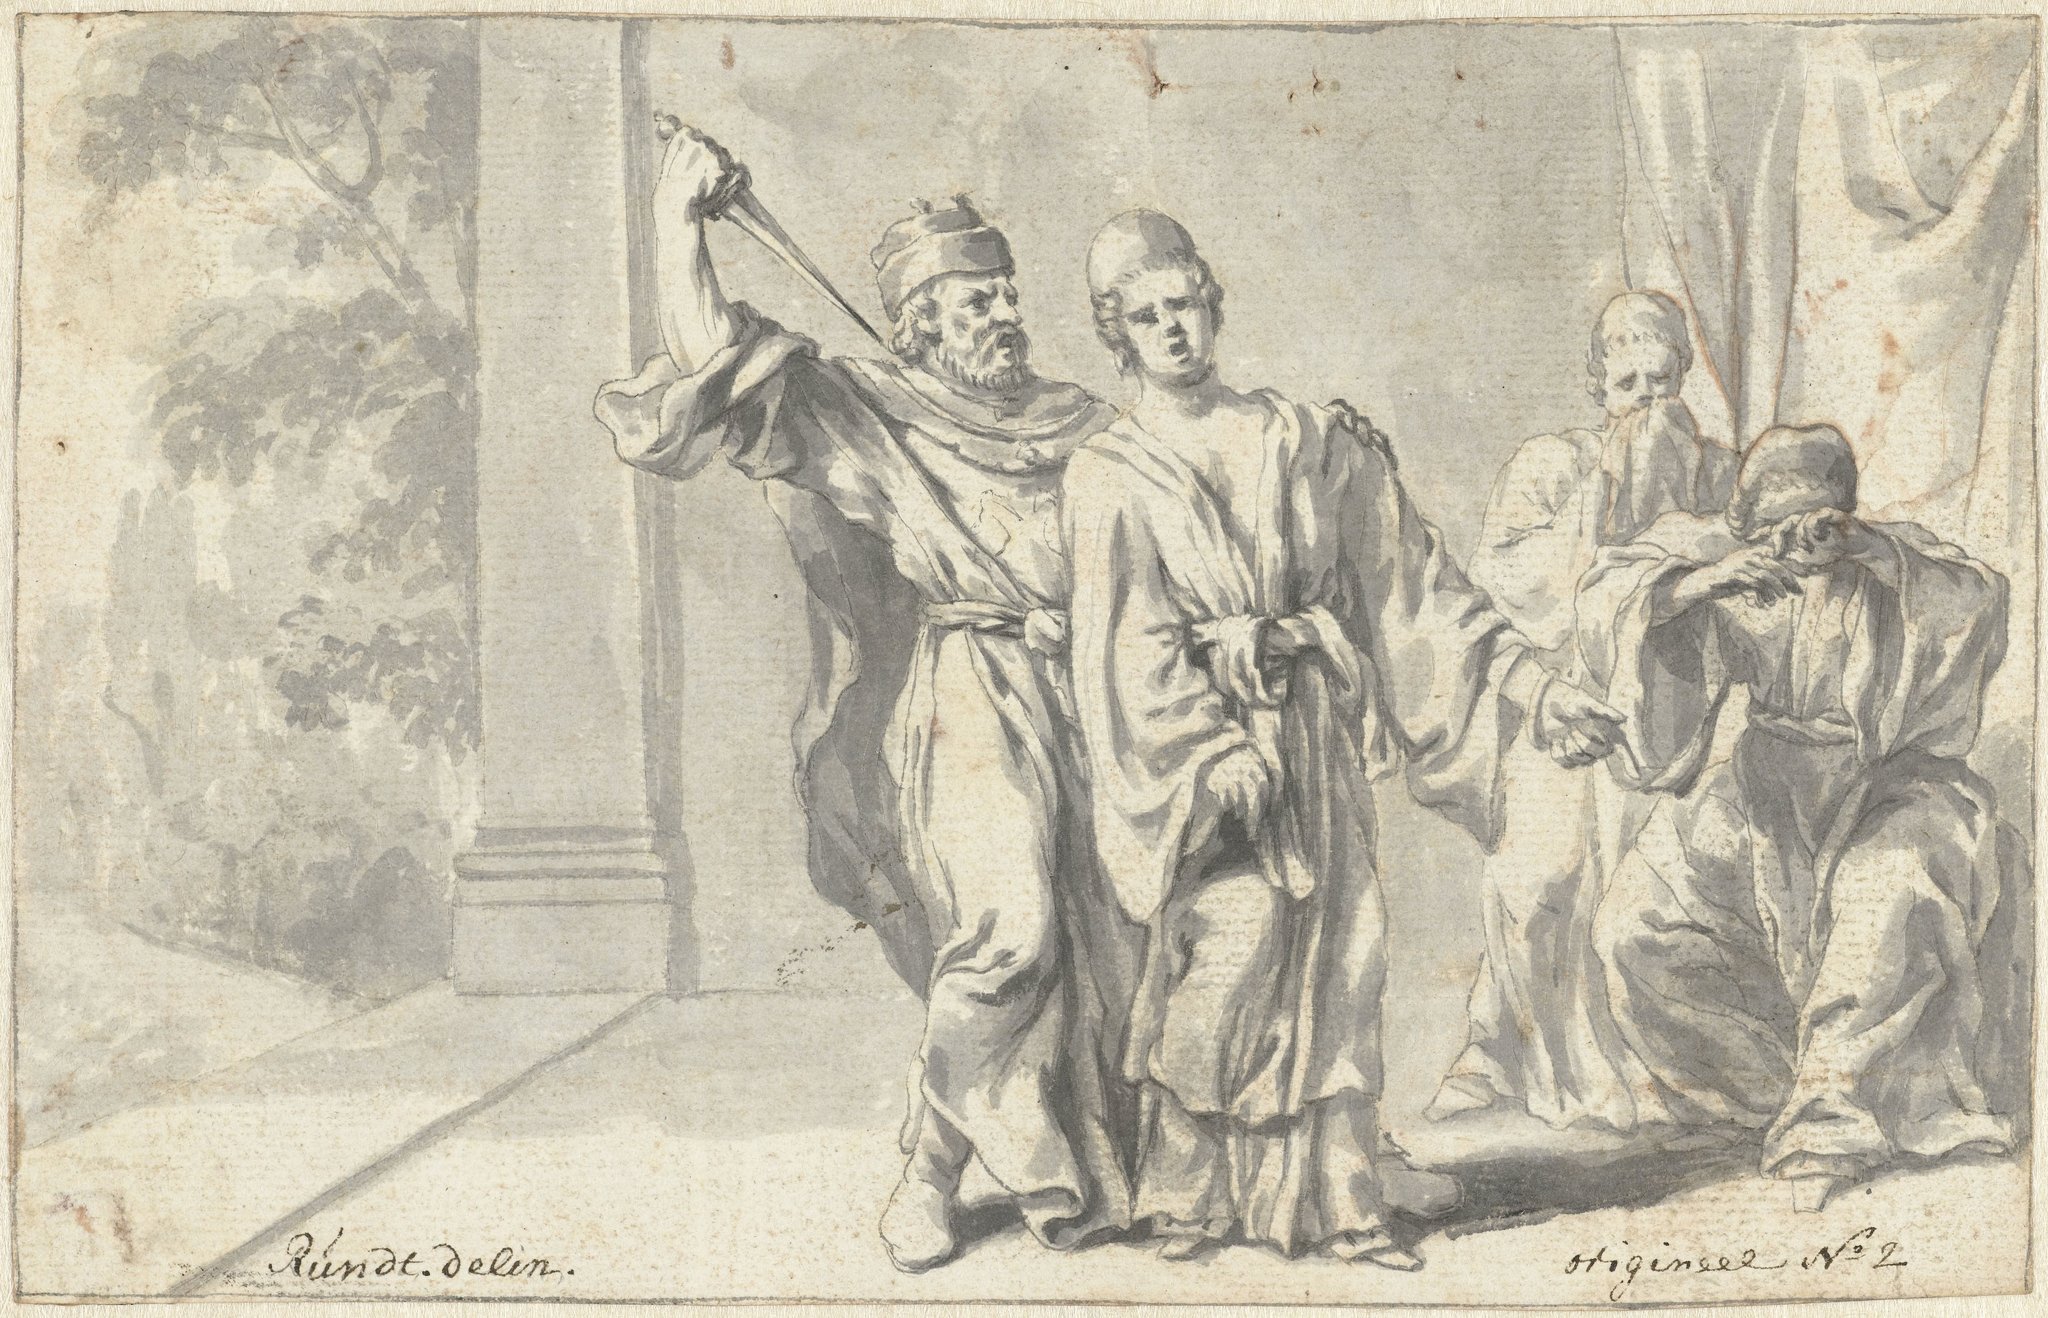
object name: drawing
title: De Chinese keizer Zunchinius doodt zijn dochter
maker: hans hinrich rundt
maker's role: draughtsman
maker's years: 1660-1750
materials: chalk, ink, paper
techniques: pouncing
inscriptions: annotation: ‘origineel No.2’, signature: ‘Rundt. delin.’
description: De Chinese keizer Zunchinius (waarschijnlijk Chóngzhēn) doodt zijn dochter. Ontwerptekening voor een plaat in Orientalische Reise-Beschreibung: Jürgen Andersen aus Schleßwig/ Der Anno Christi 1644 außgezogen/ und 1650 wieder kommen. Und Volquard Iversen aus Hollstein/ [...] : Sind beyde respective durch Ost-Indien/ Sina, Tartarien/ Persien/ Türckeyen/ Arabien und Palestinam gezogen: und haben zu Wasser und Land viel merckliche [...] / Heraus gegeben Durch Adam Olearium ... Mit dessen Notis, und etlicher Oerter Erklärungen: Sampt vielen Kupfferstücken ... Hamburg, 1696.